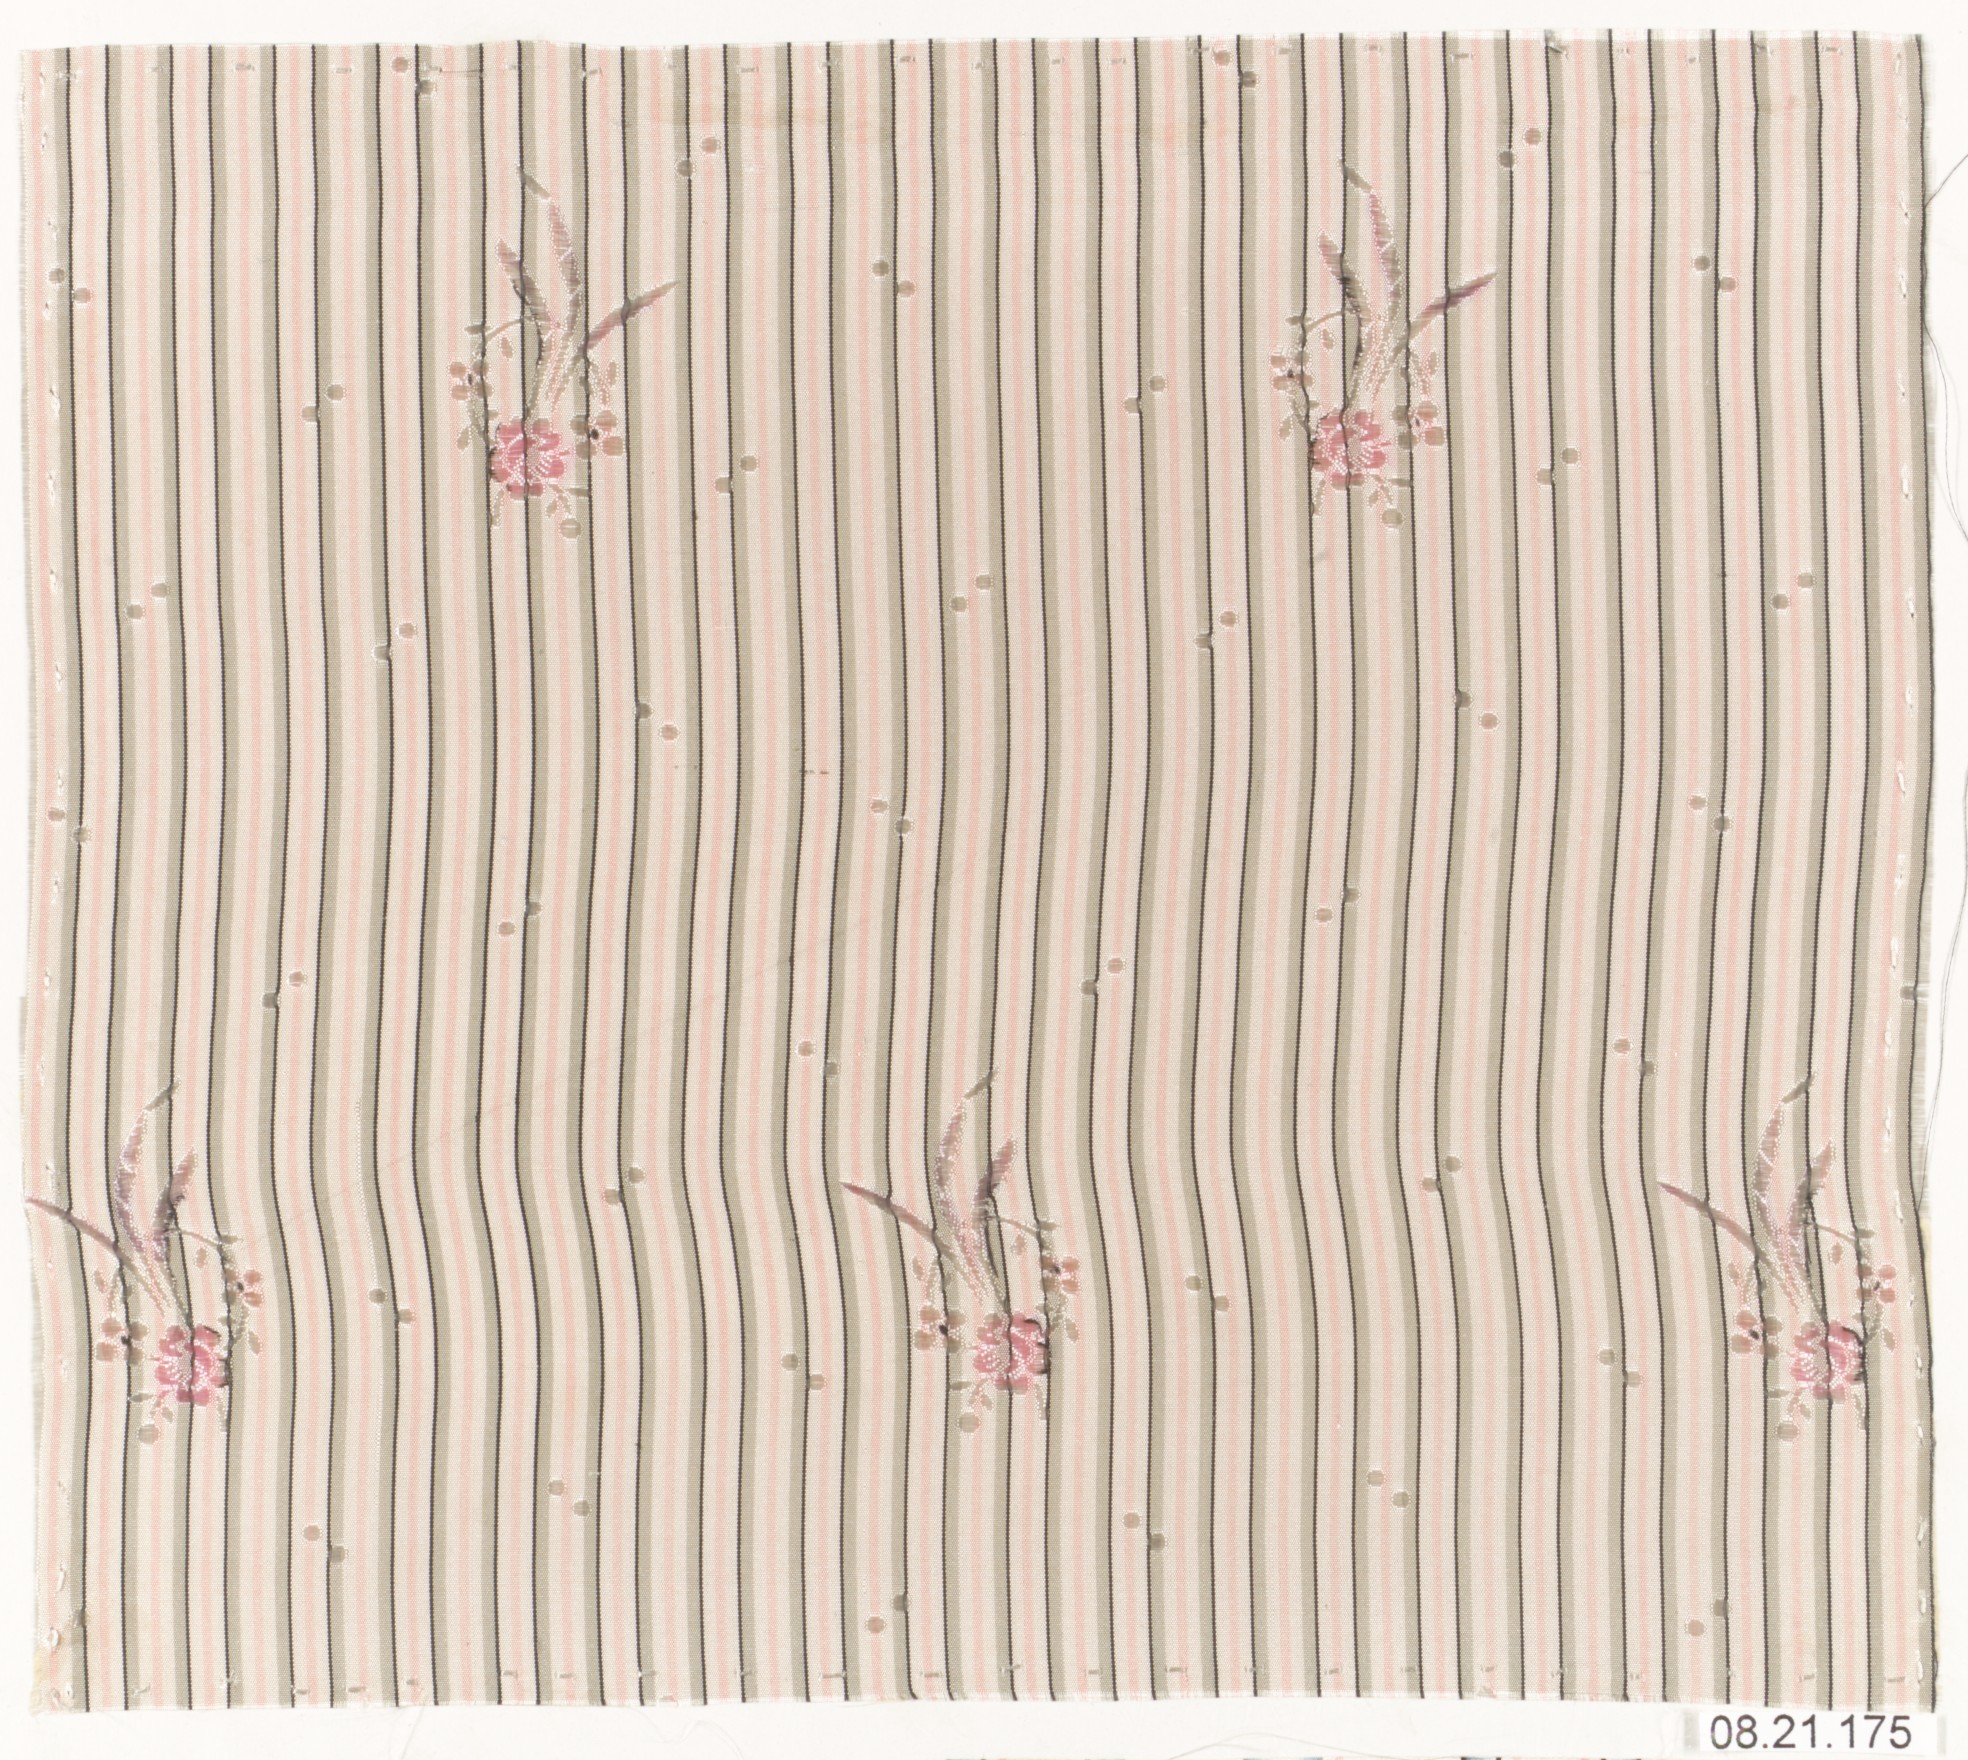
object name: textile sample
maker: Anonymous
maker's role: designer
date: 1900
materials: silk